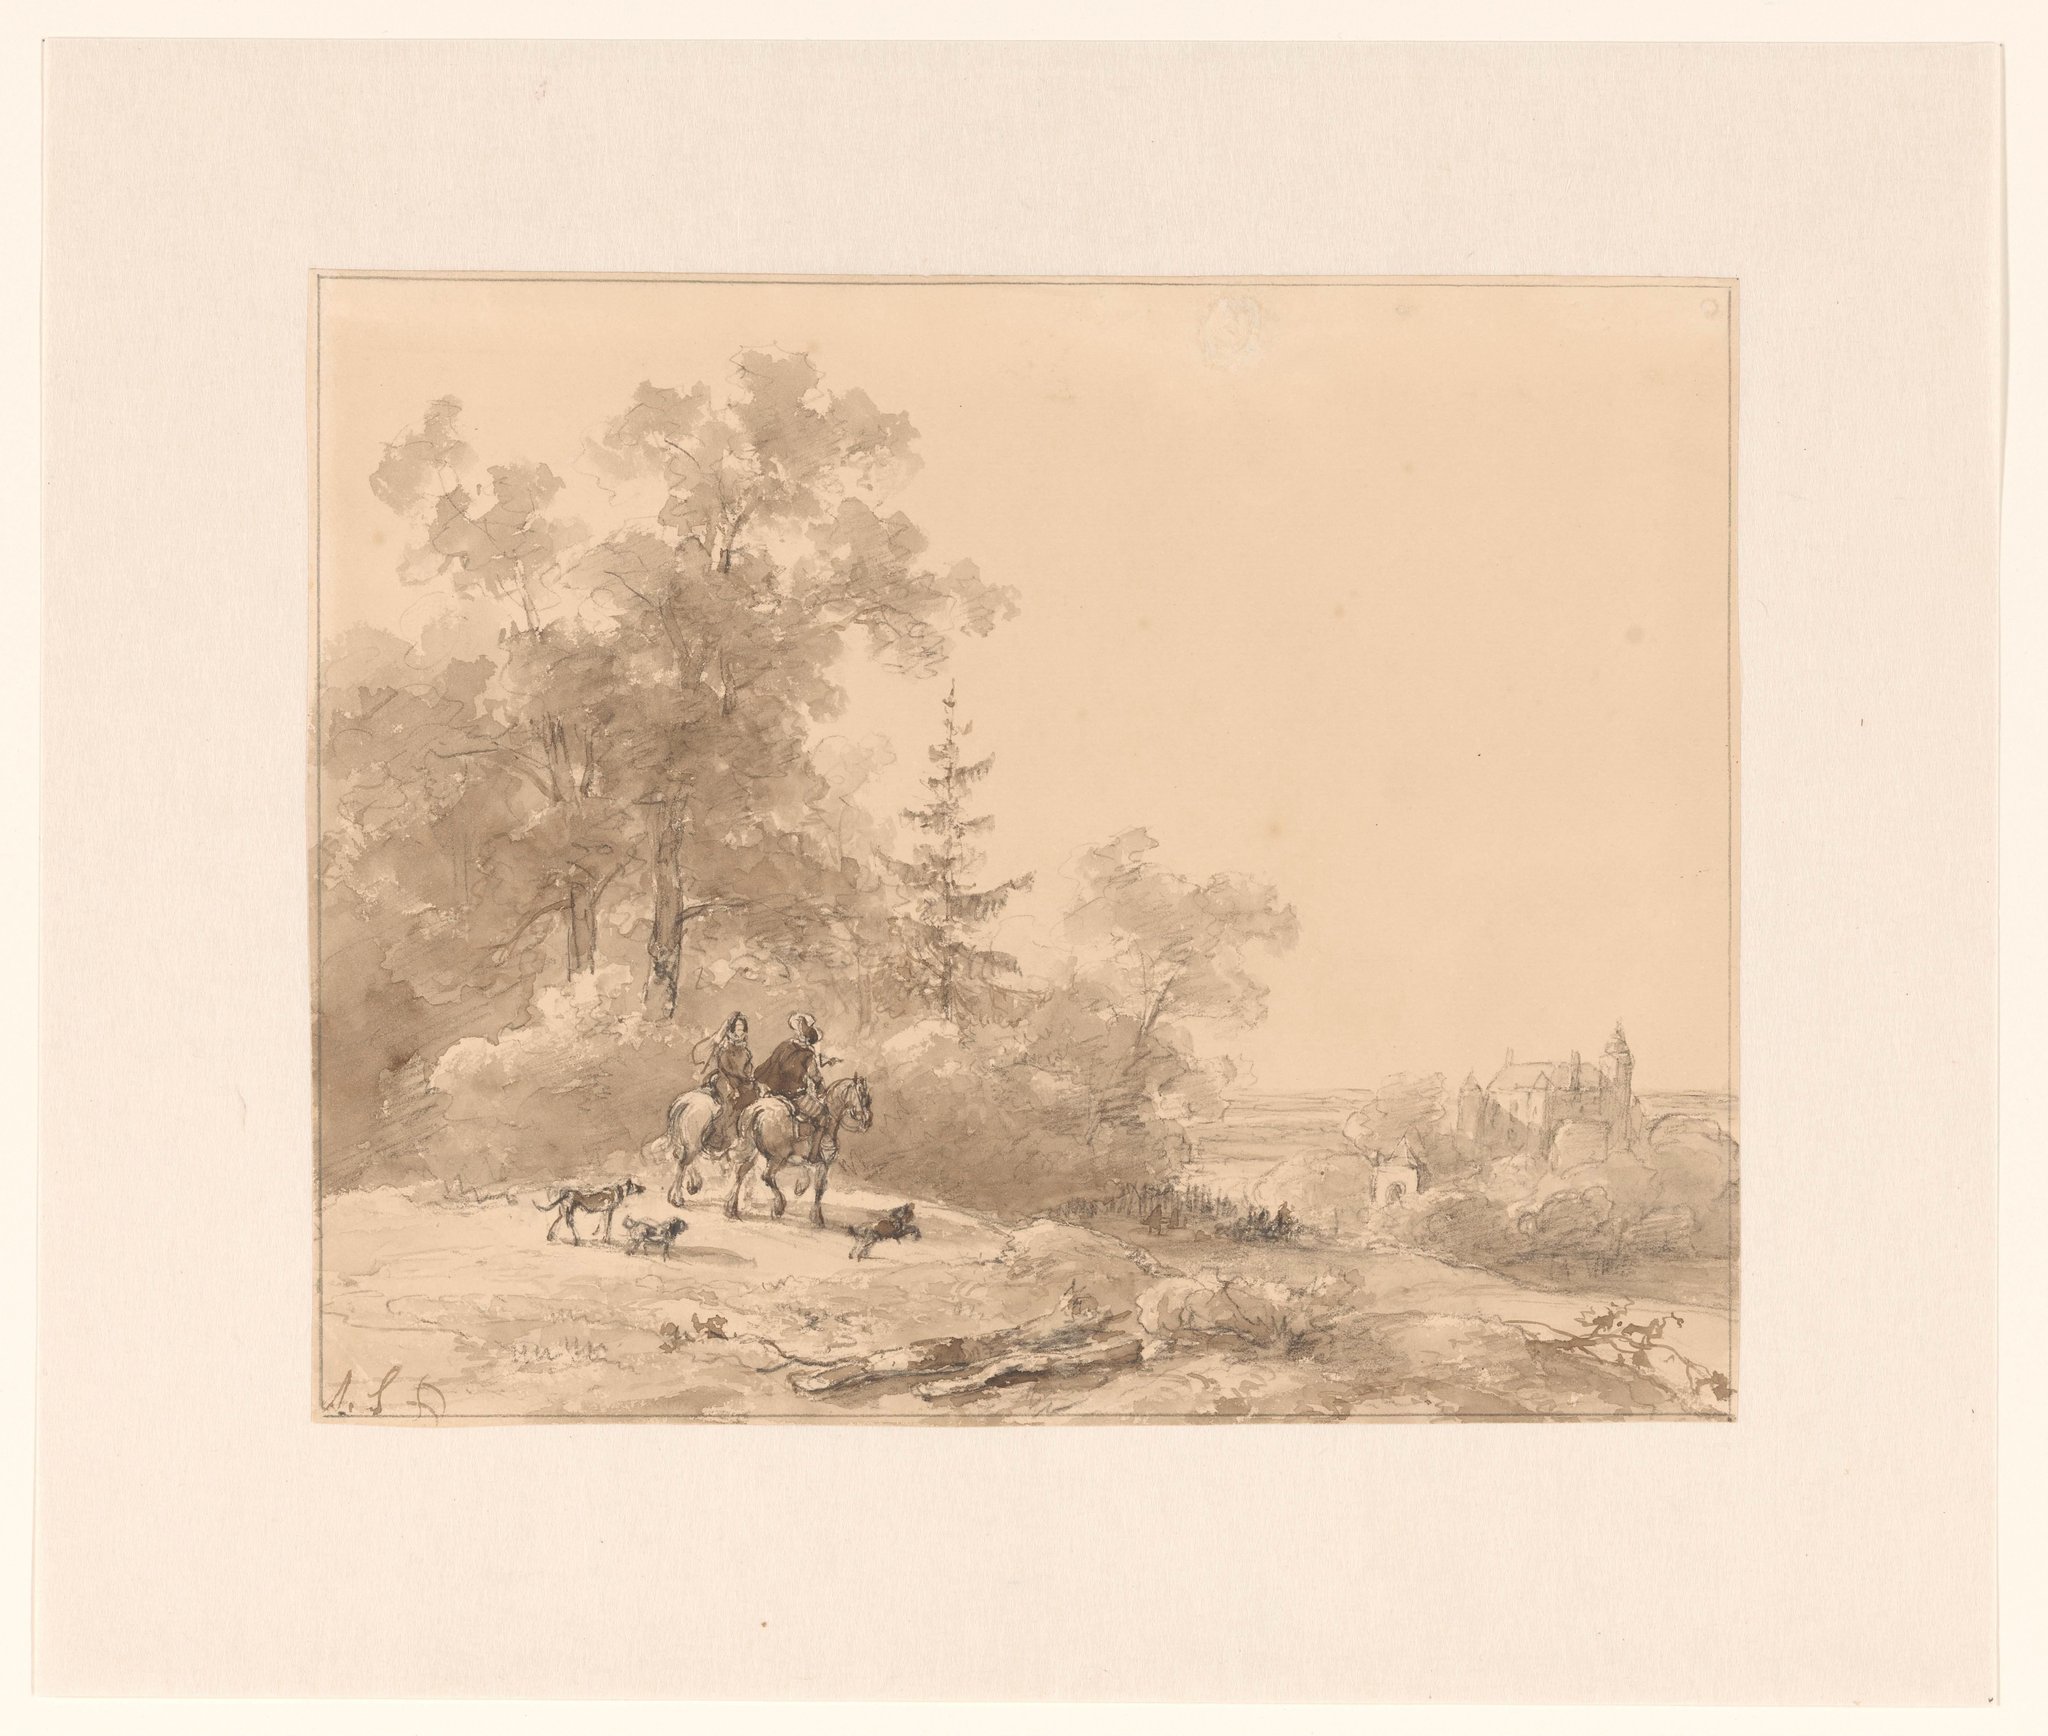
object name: drawing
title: Twee ruiters vergezeld door enkele honden op weg naar het kasteel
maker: andreas schelfhout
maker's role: draughtsman, painter, print maker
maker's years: 1787-1870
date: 1797-1870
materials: chalk, paper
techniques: brush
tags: landscapes, castle, horse-racing, horse, dog